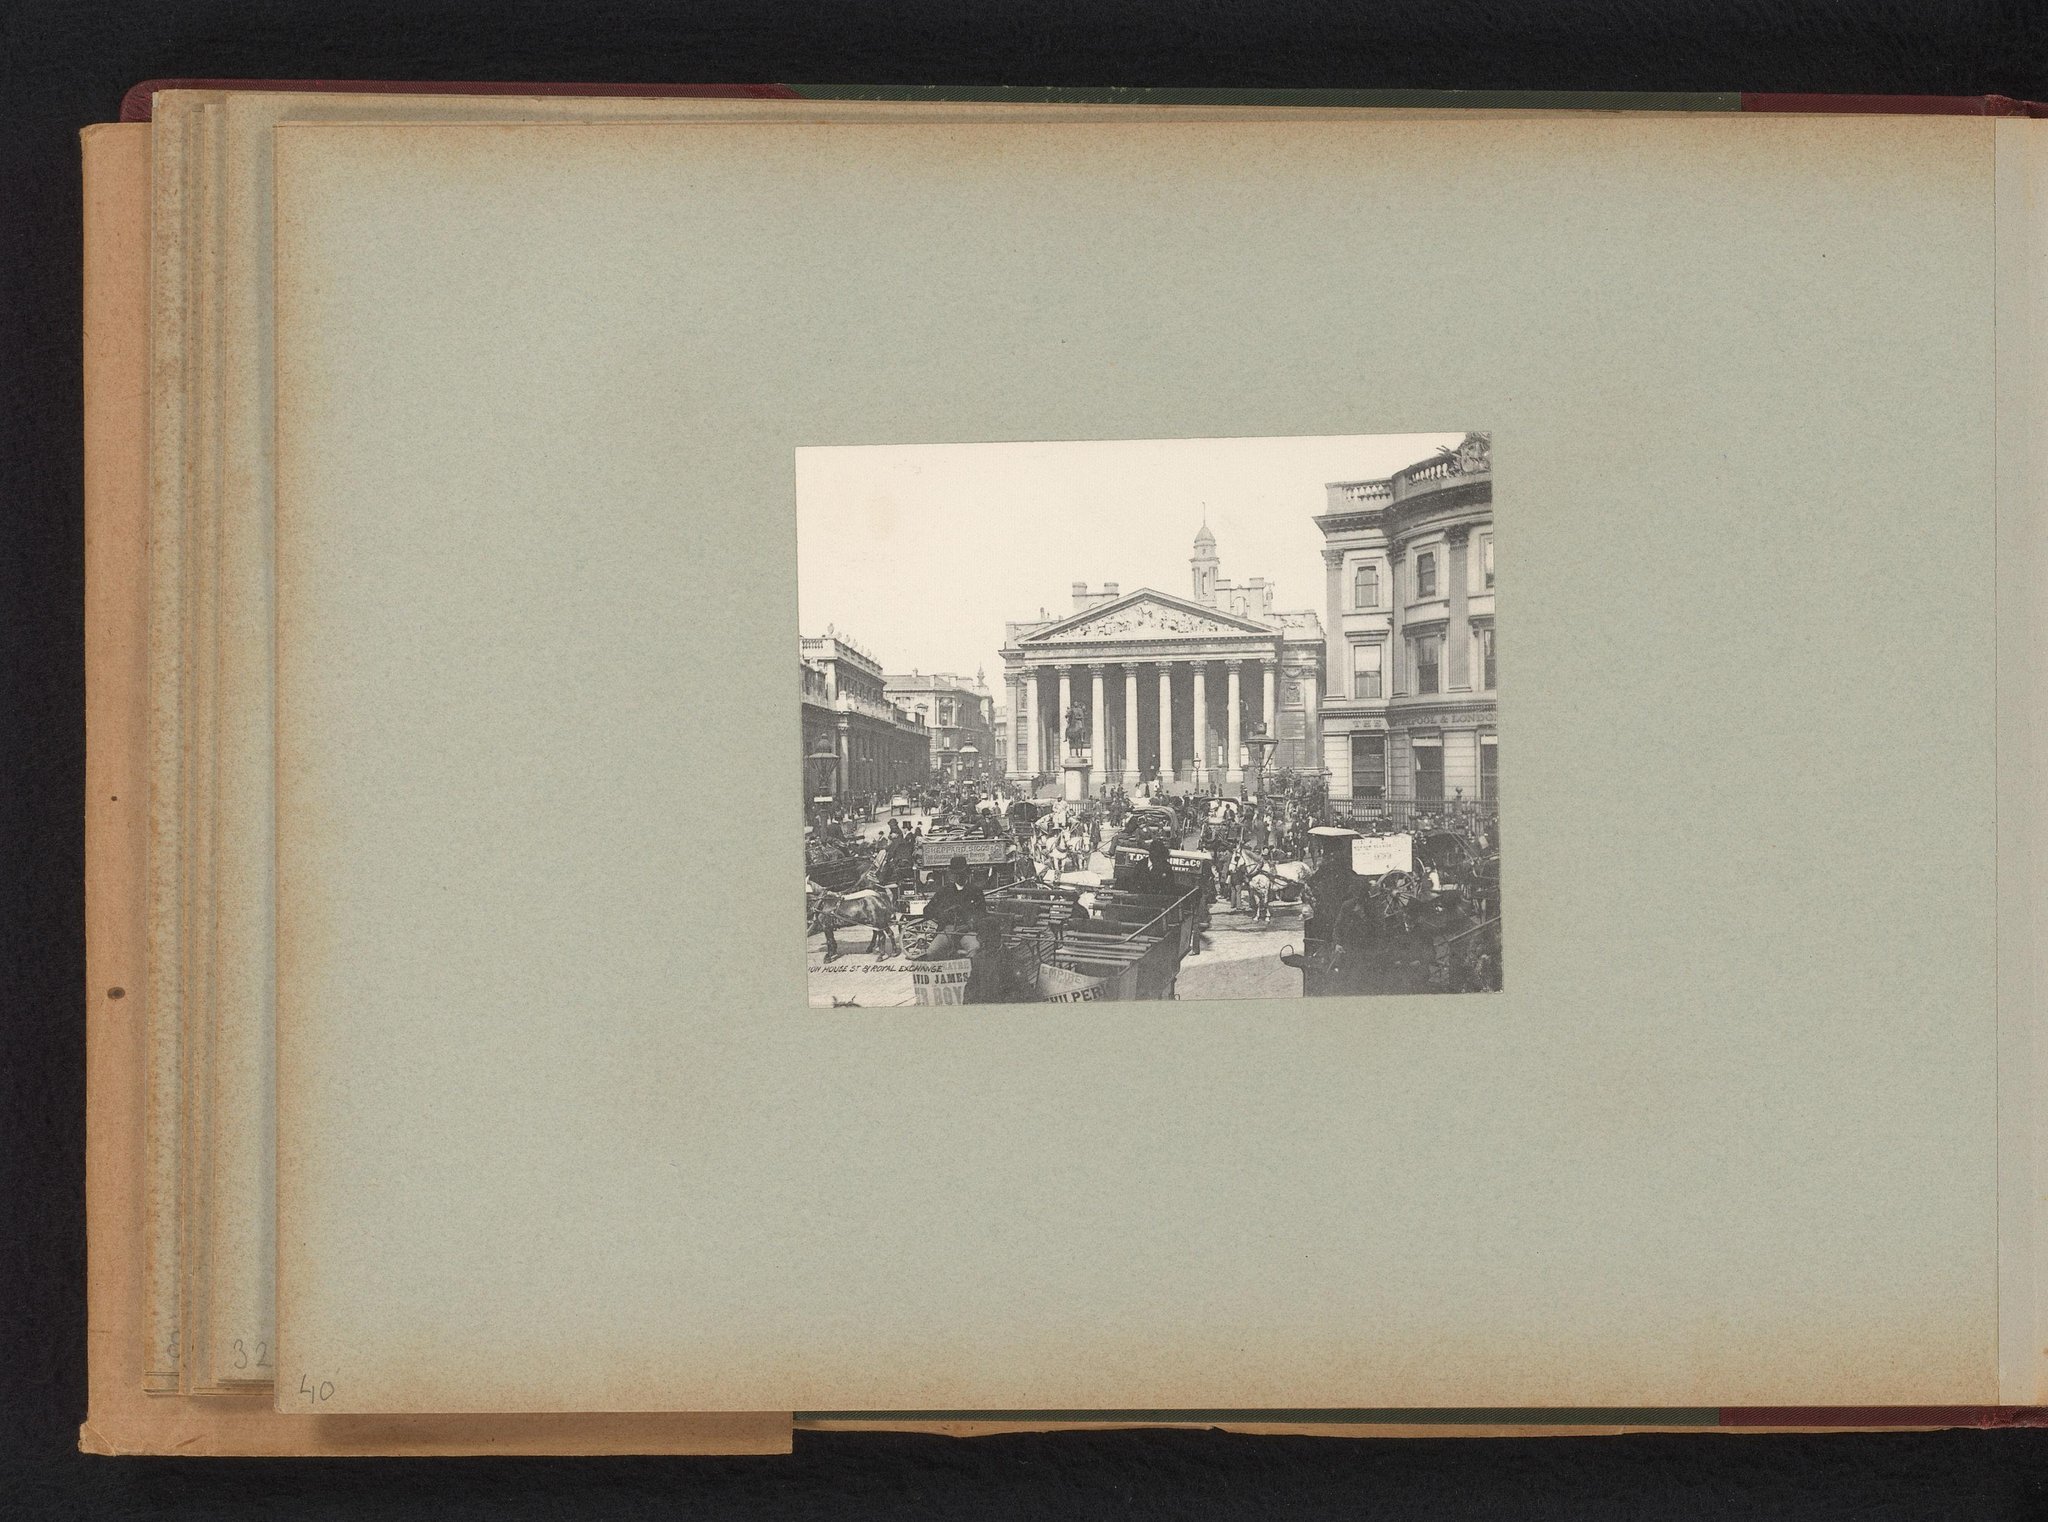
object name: photomechanical print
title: Union House Street & Royal Exchange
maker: Anonymous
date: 1880-1900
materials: paper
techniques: photograph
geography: london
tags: exchange, bourse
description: Deze prent maakt deel uit van een album.